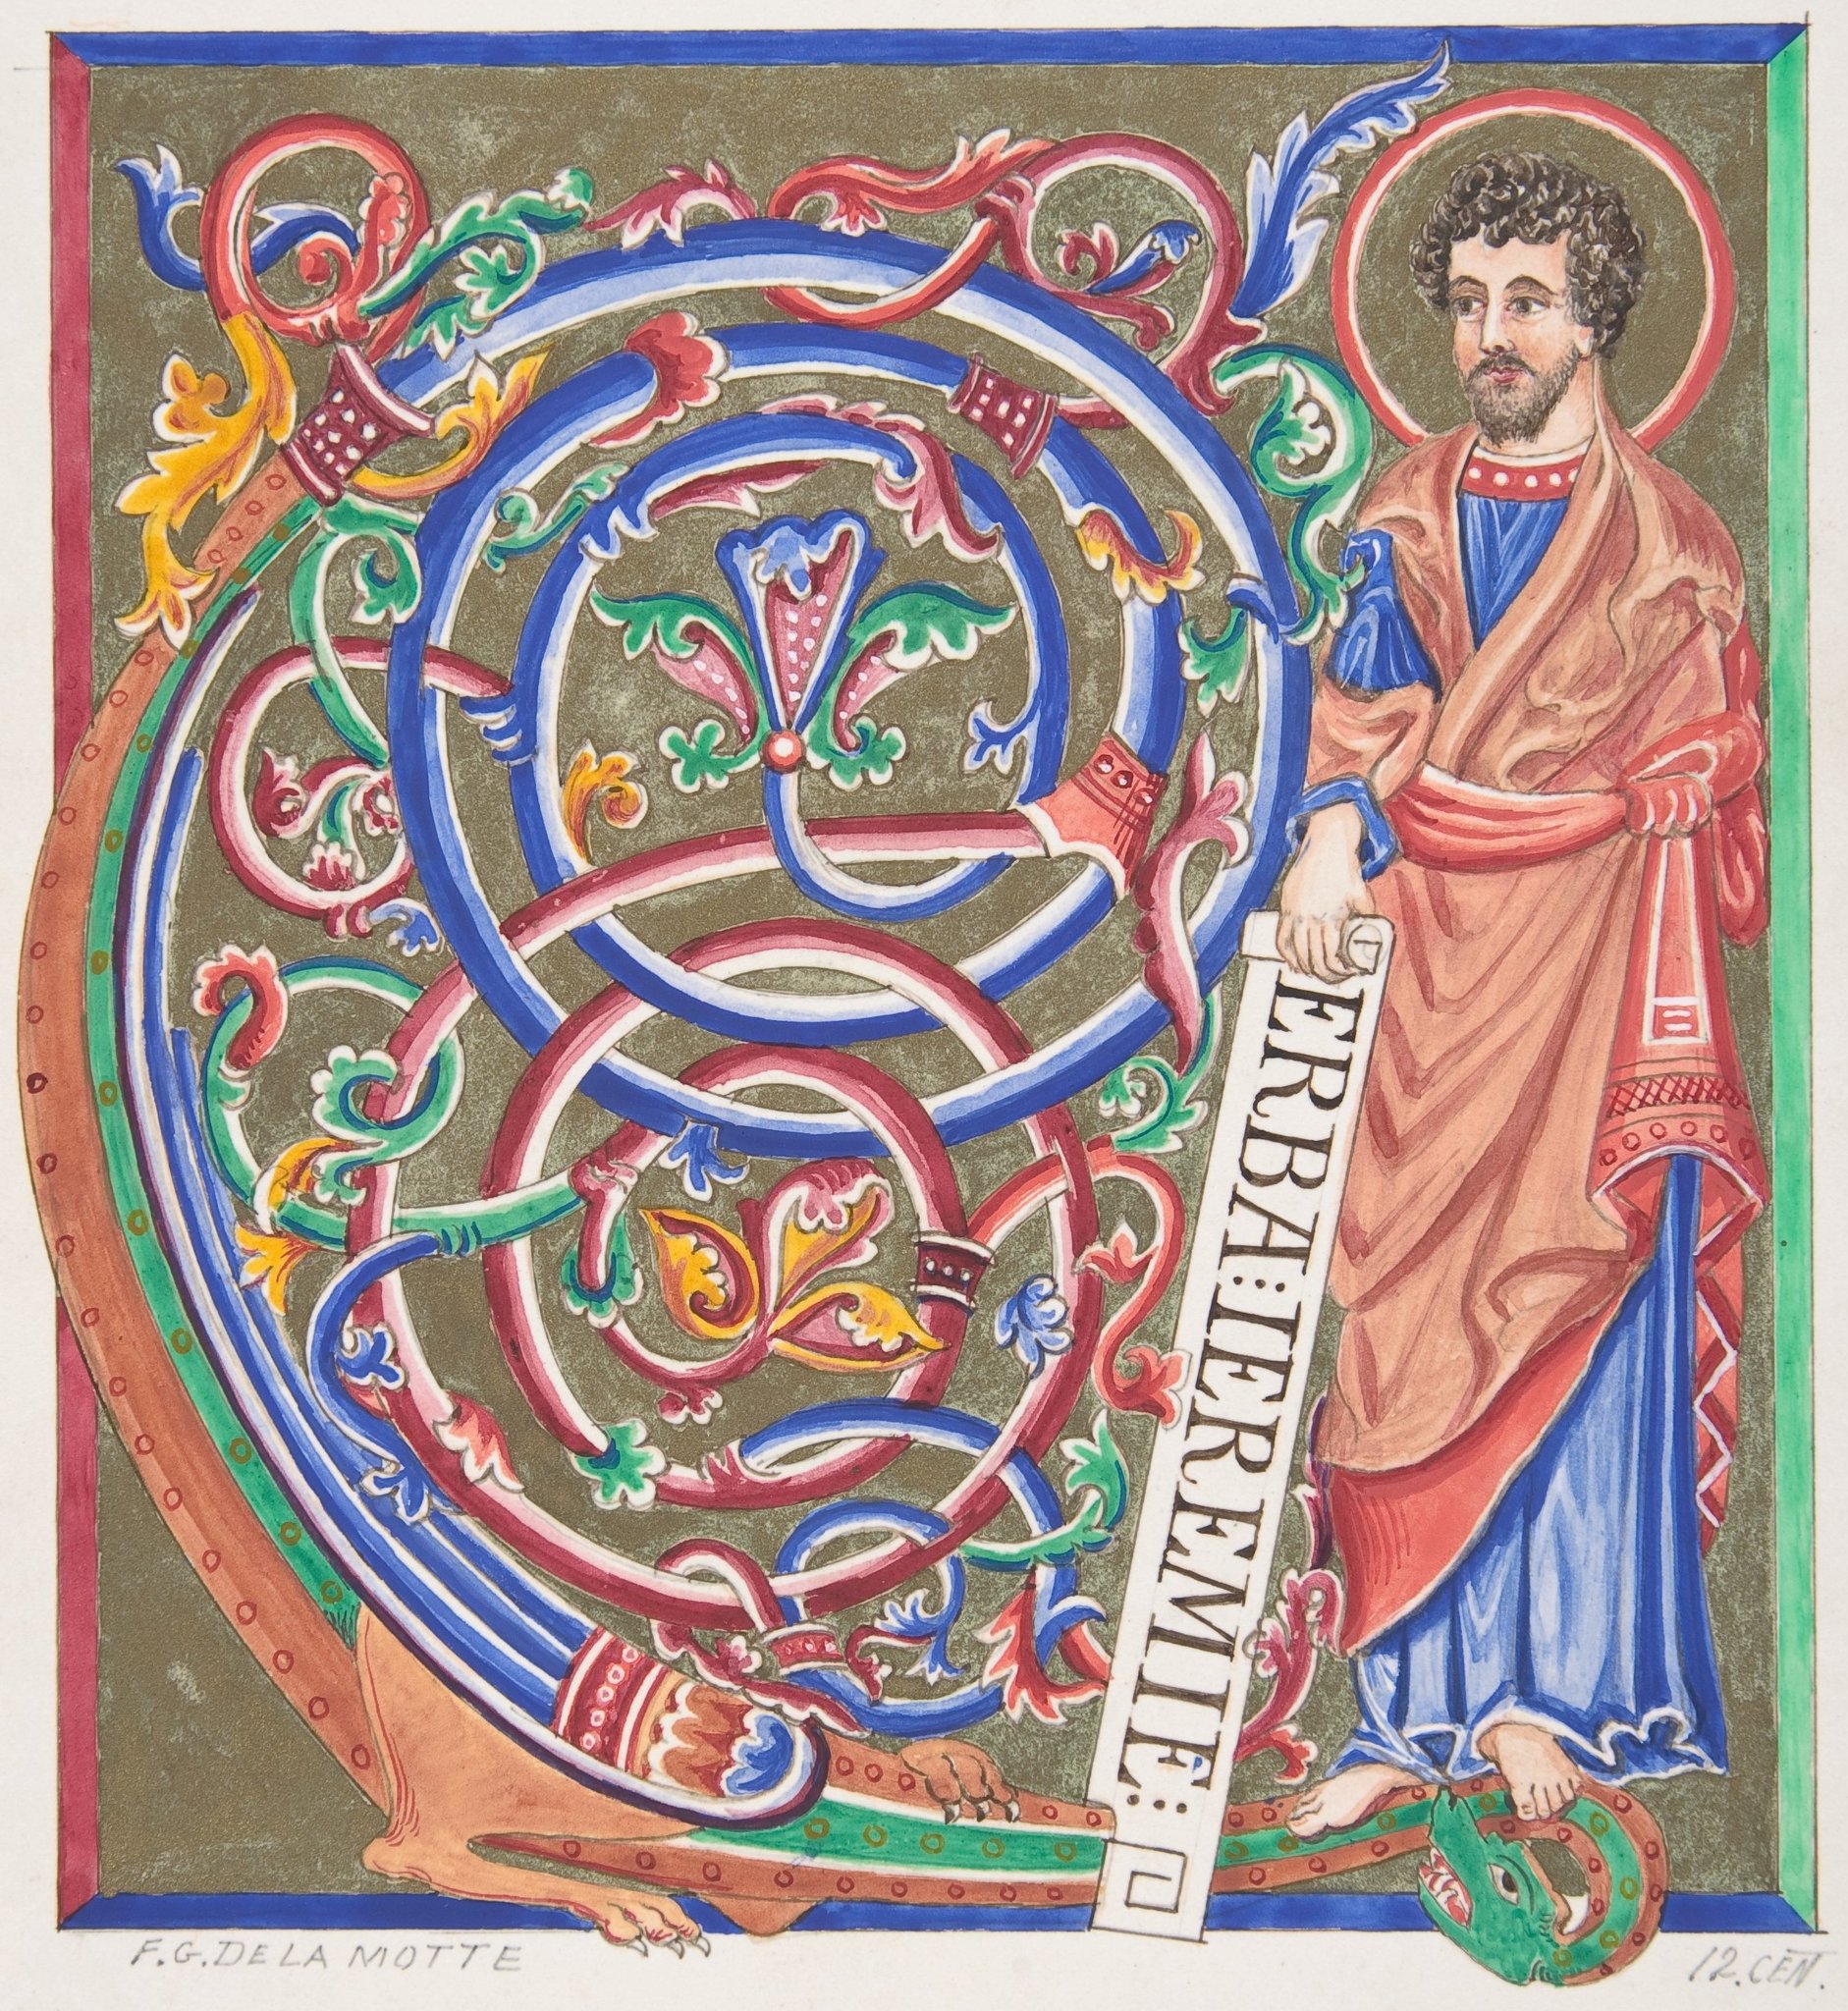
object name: drawing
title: Illuminated Initial and Saint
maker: freeman gage delamotte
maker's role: artist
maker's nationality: british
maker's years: 1813-1862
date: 1830-1862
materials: gold, gouache, graphite, ink, watercolor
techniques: pen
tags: saints